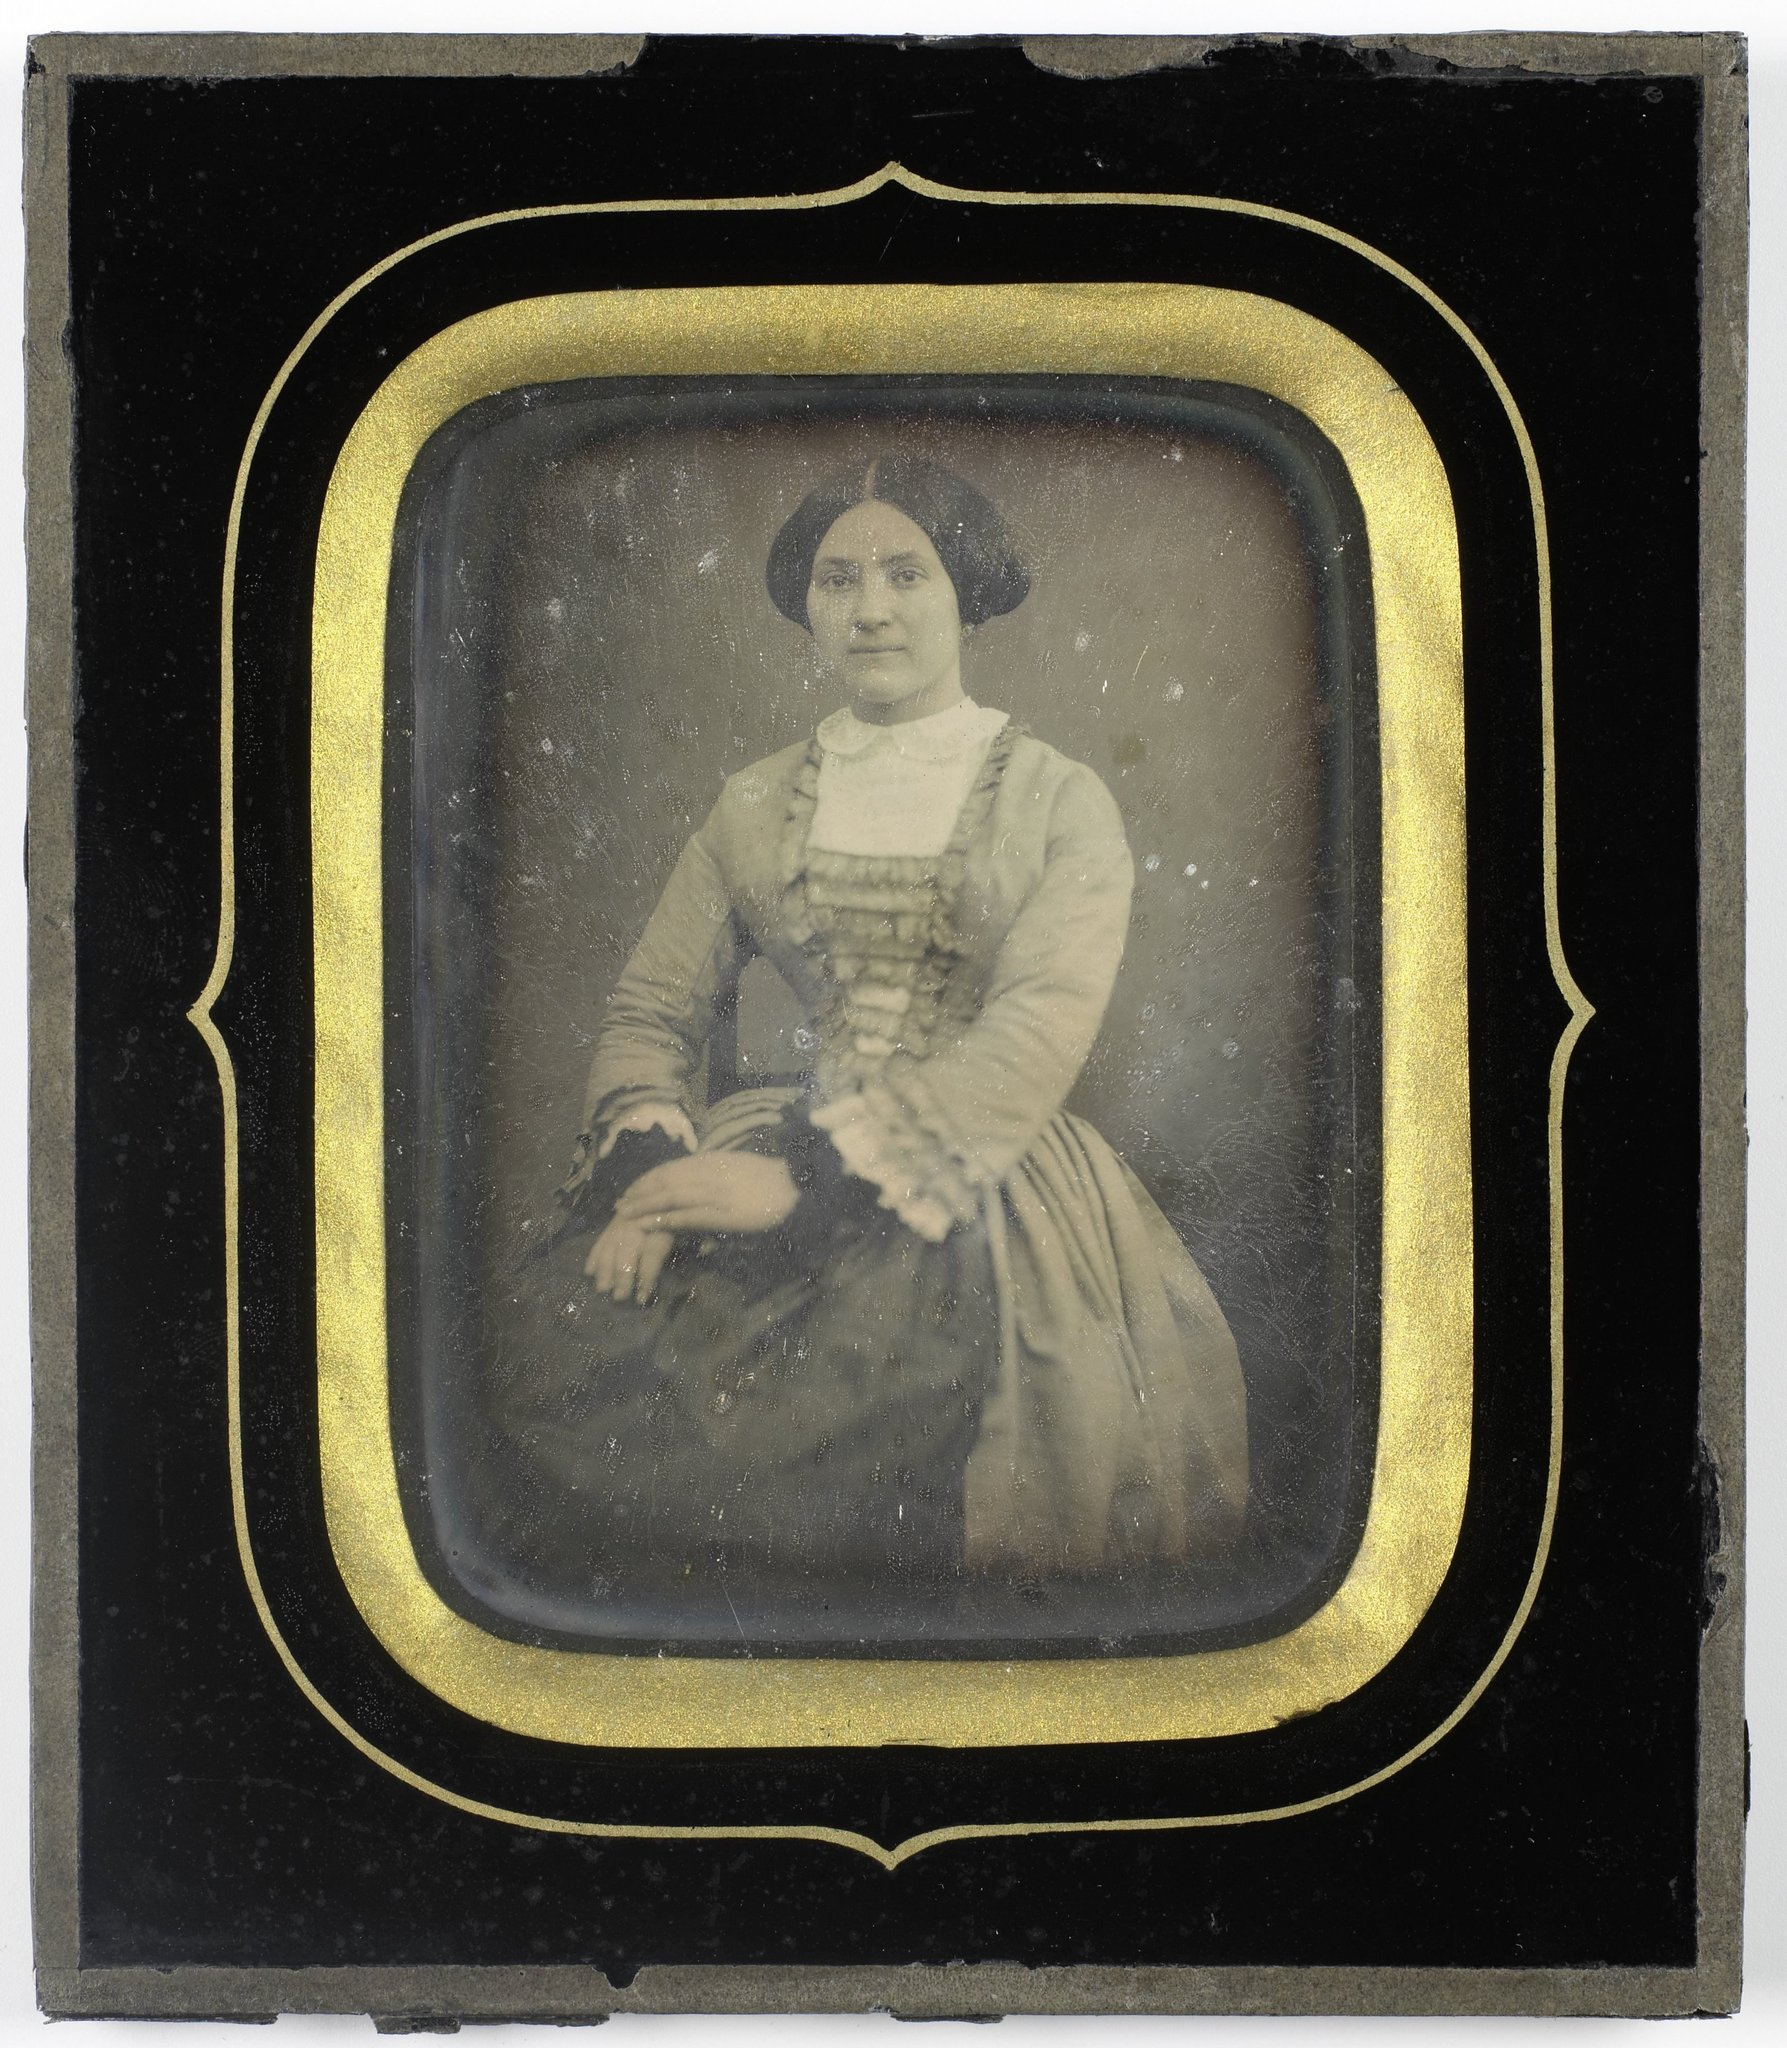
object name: photograph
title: Portret van een onbekende jonge vrouw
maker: m. ruef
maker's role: fotograaf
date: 1840-1860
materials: copper, glass, paper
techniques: daguerreotype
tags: adult woman, historical persons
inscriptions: inscription: ‘41 Faubourg St. Denis, Paris’